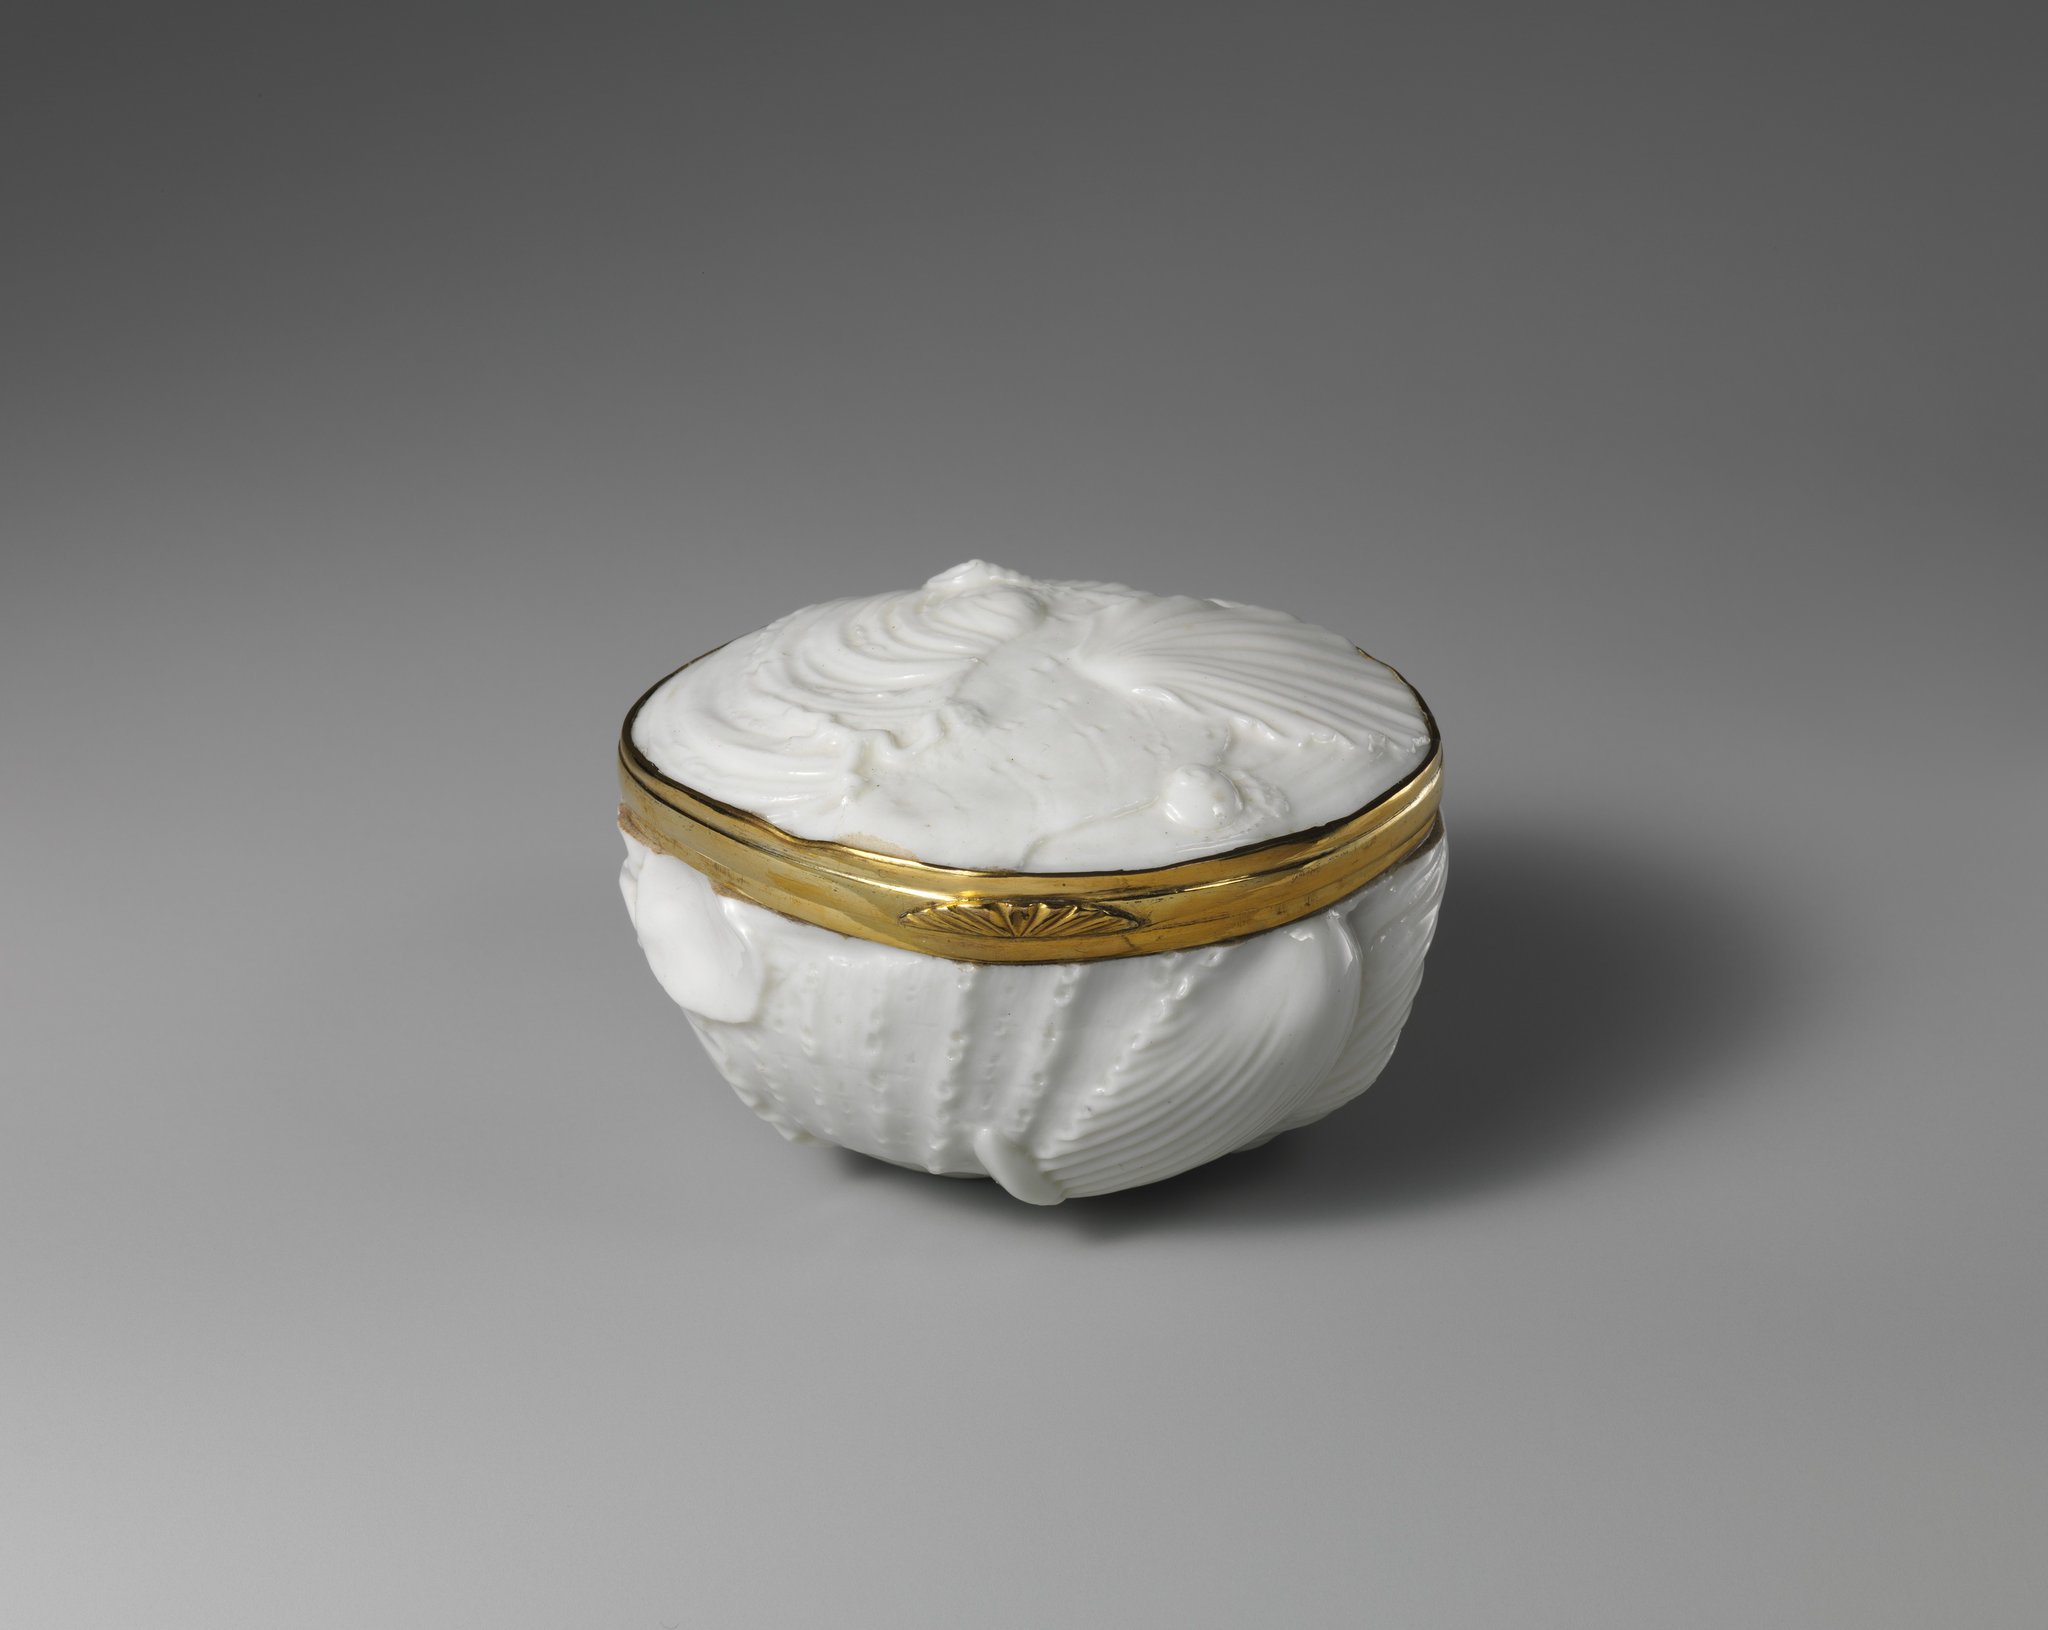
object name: snuffbox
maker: capodimonte porcelain manufactory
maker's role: manufactory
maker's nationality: italian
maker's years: 1740-1759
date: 1745-1750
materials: gold, soft paste porcelain